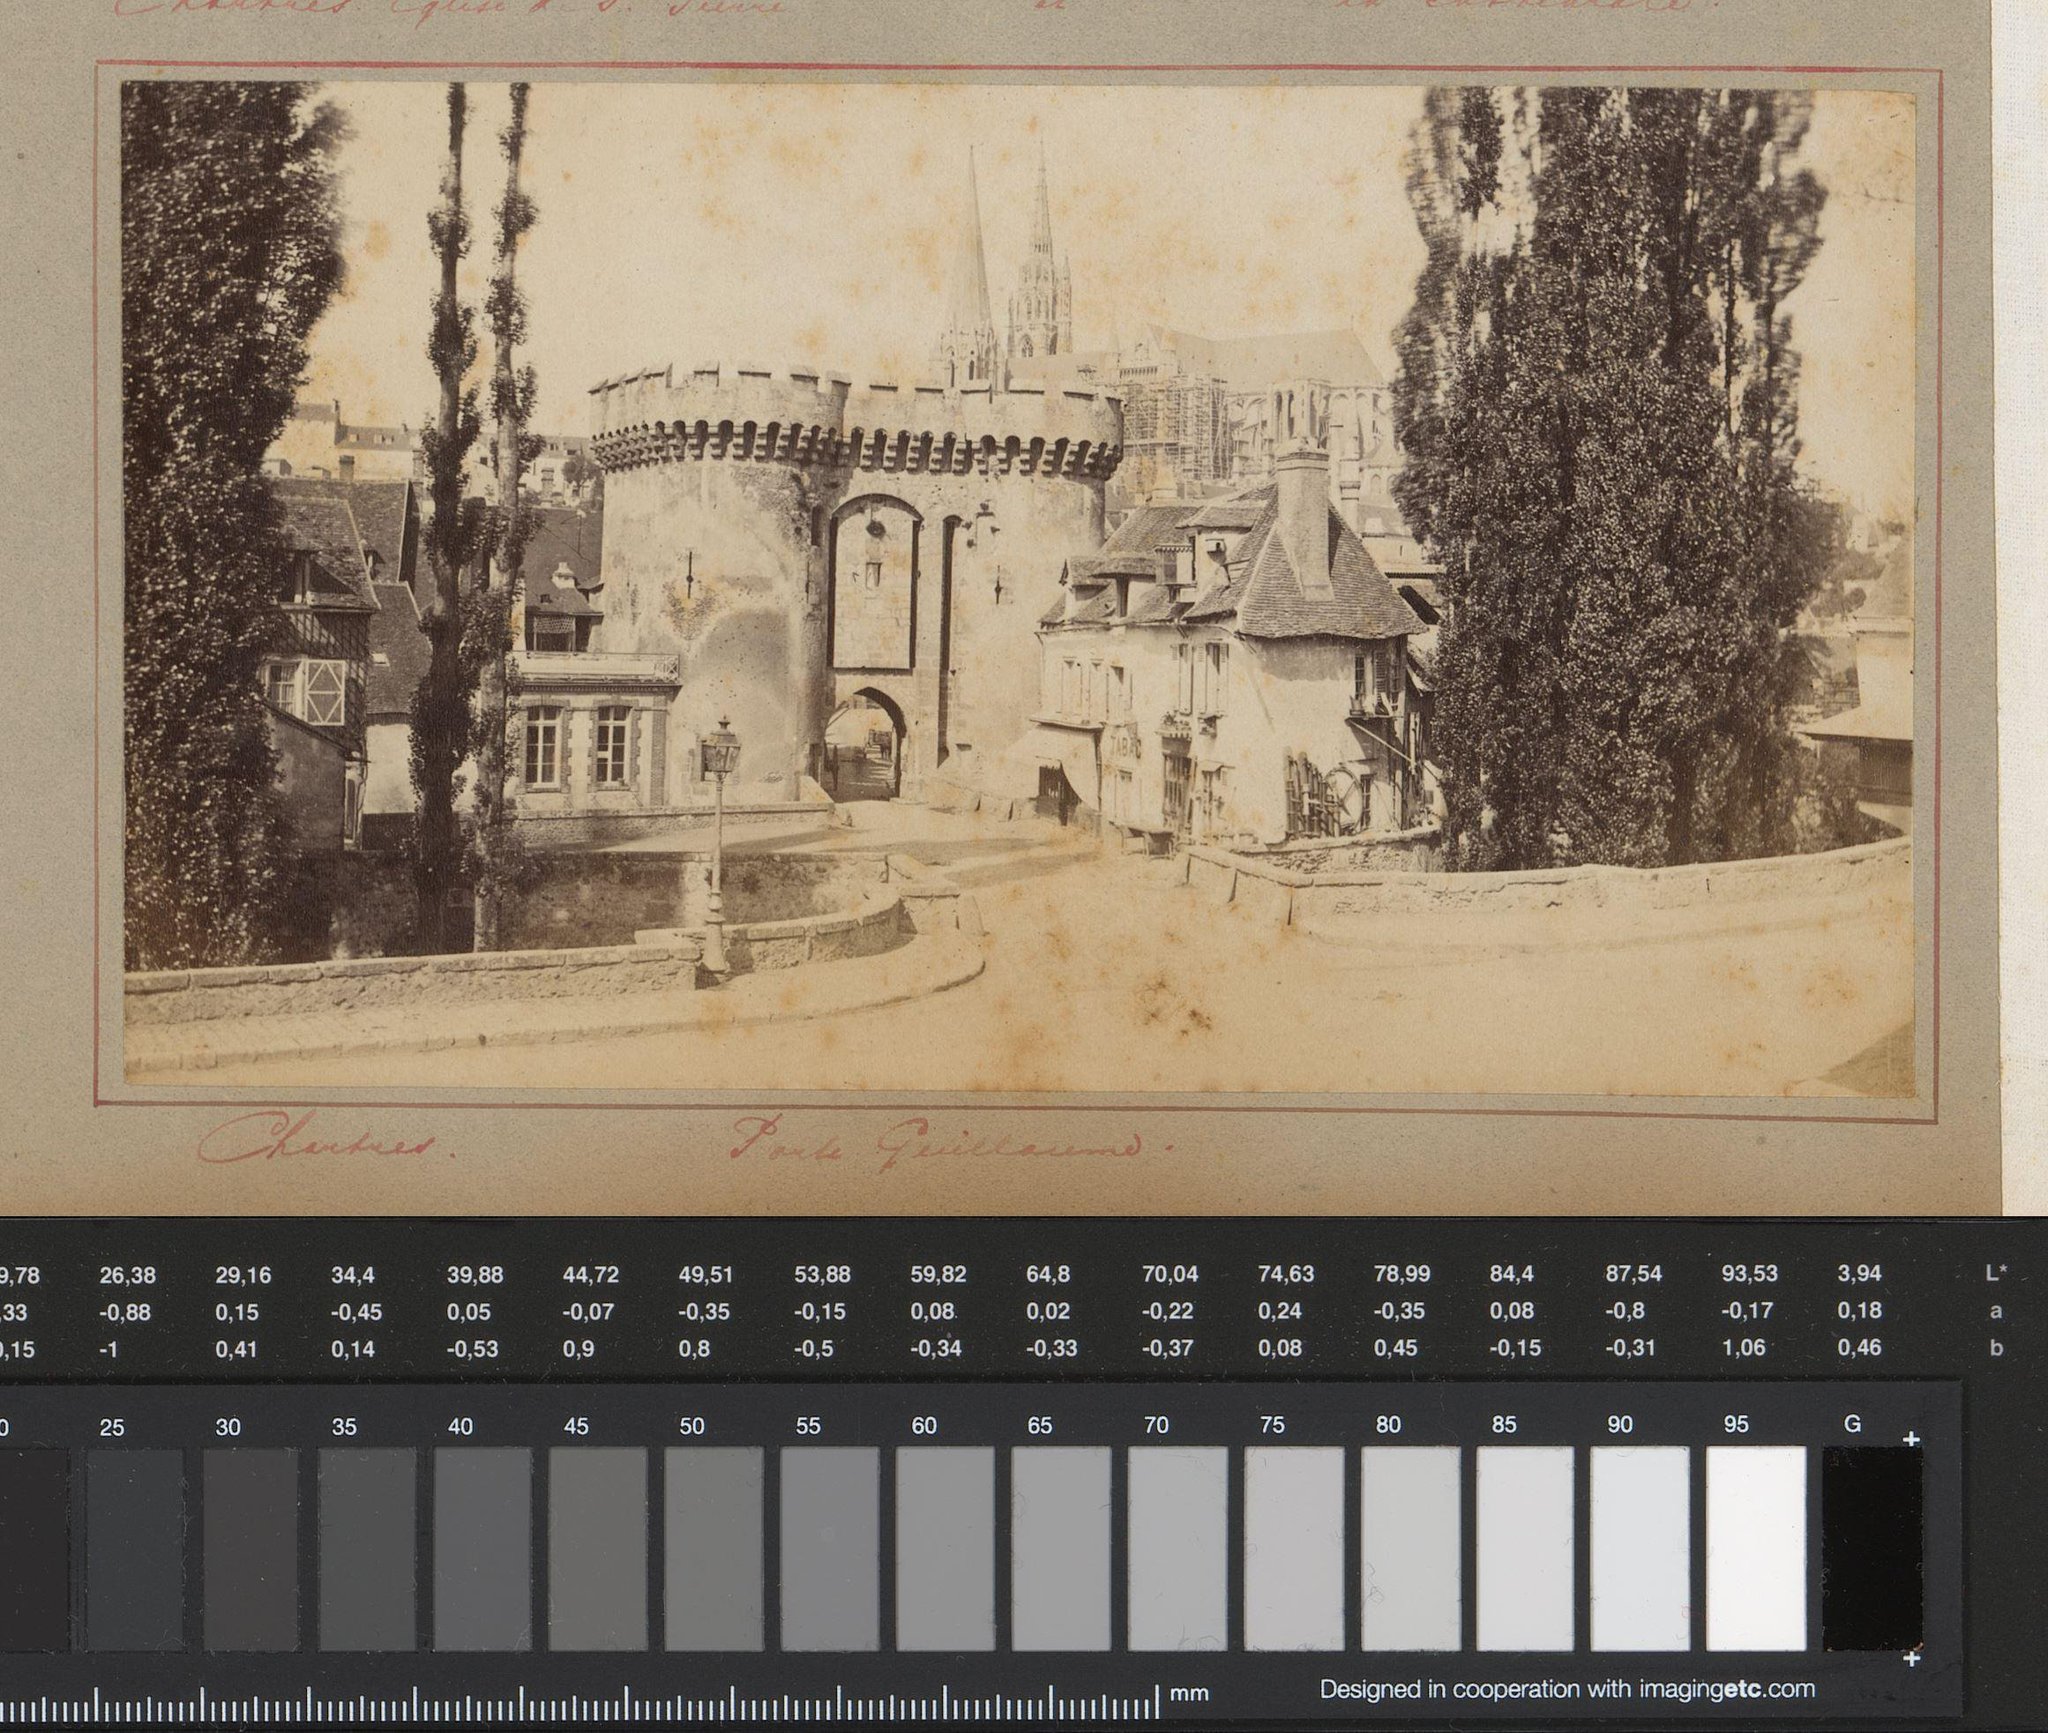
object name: photograph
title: Gezicht op Chartres met de Porte Guillaume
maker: Anonymous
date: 1880-1910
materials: photographic support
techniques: albumen print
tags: city-view, and landscape with man-made constructions, city-gate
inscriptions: annotation: ‘Chartres Porte Guillaume’